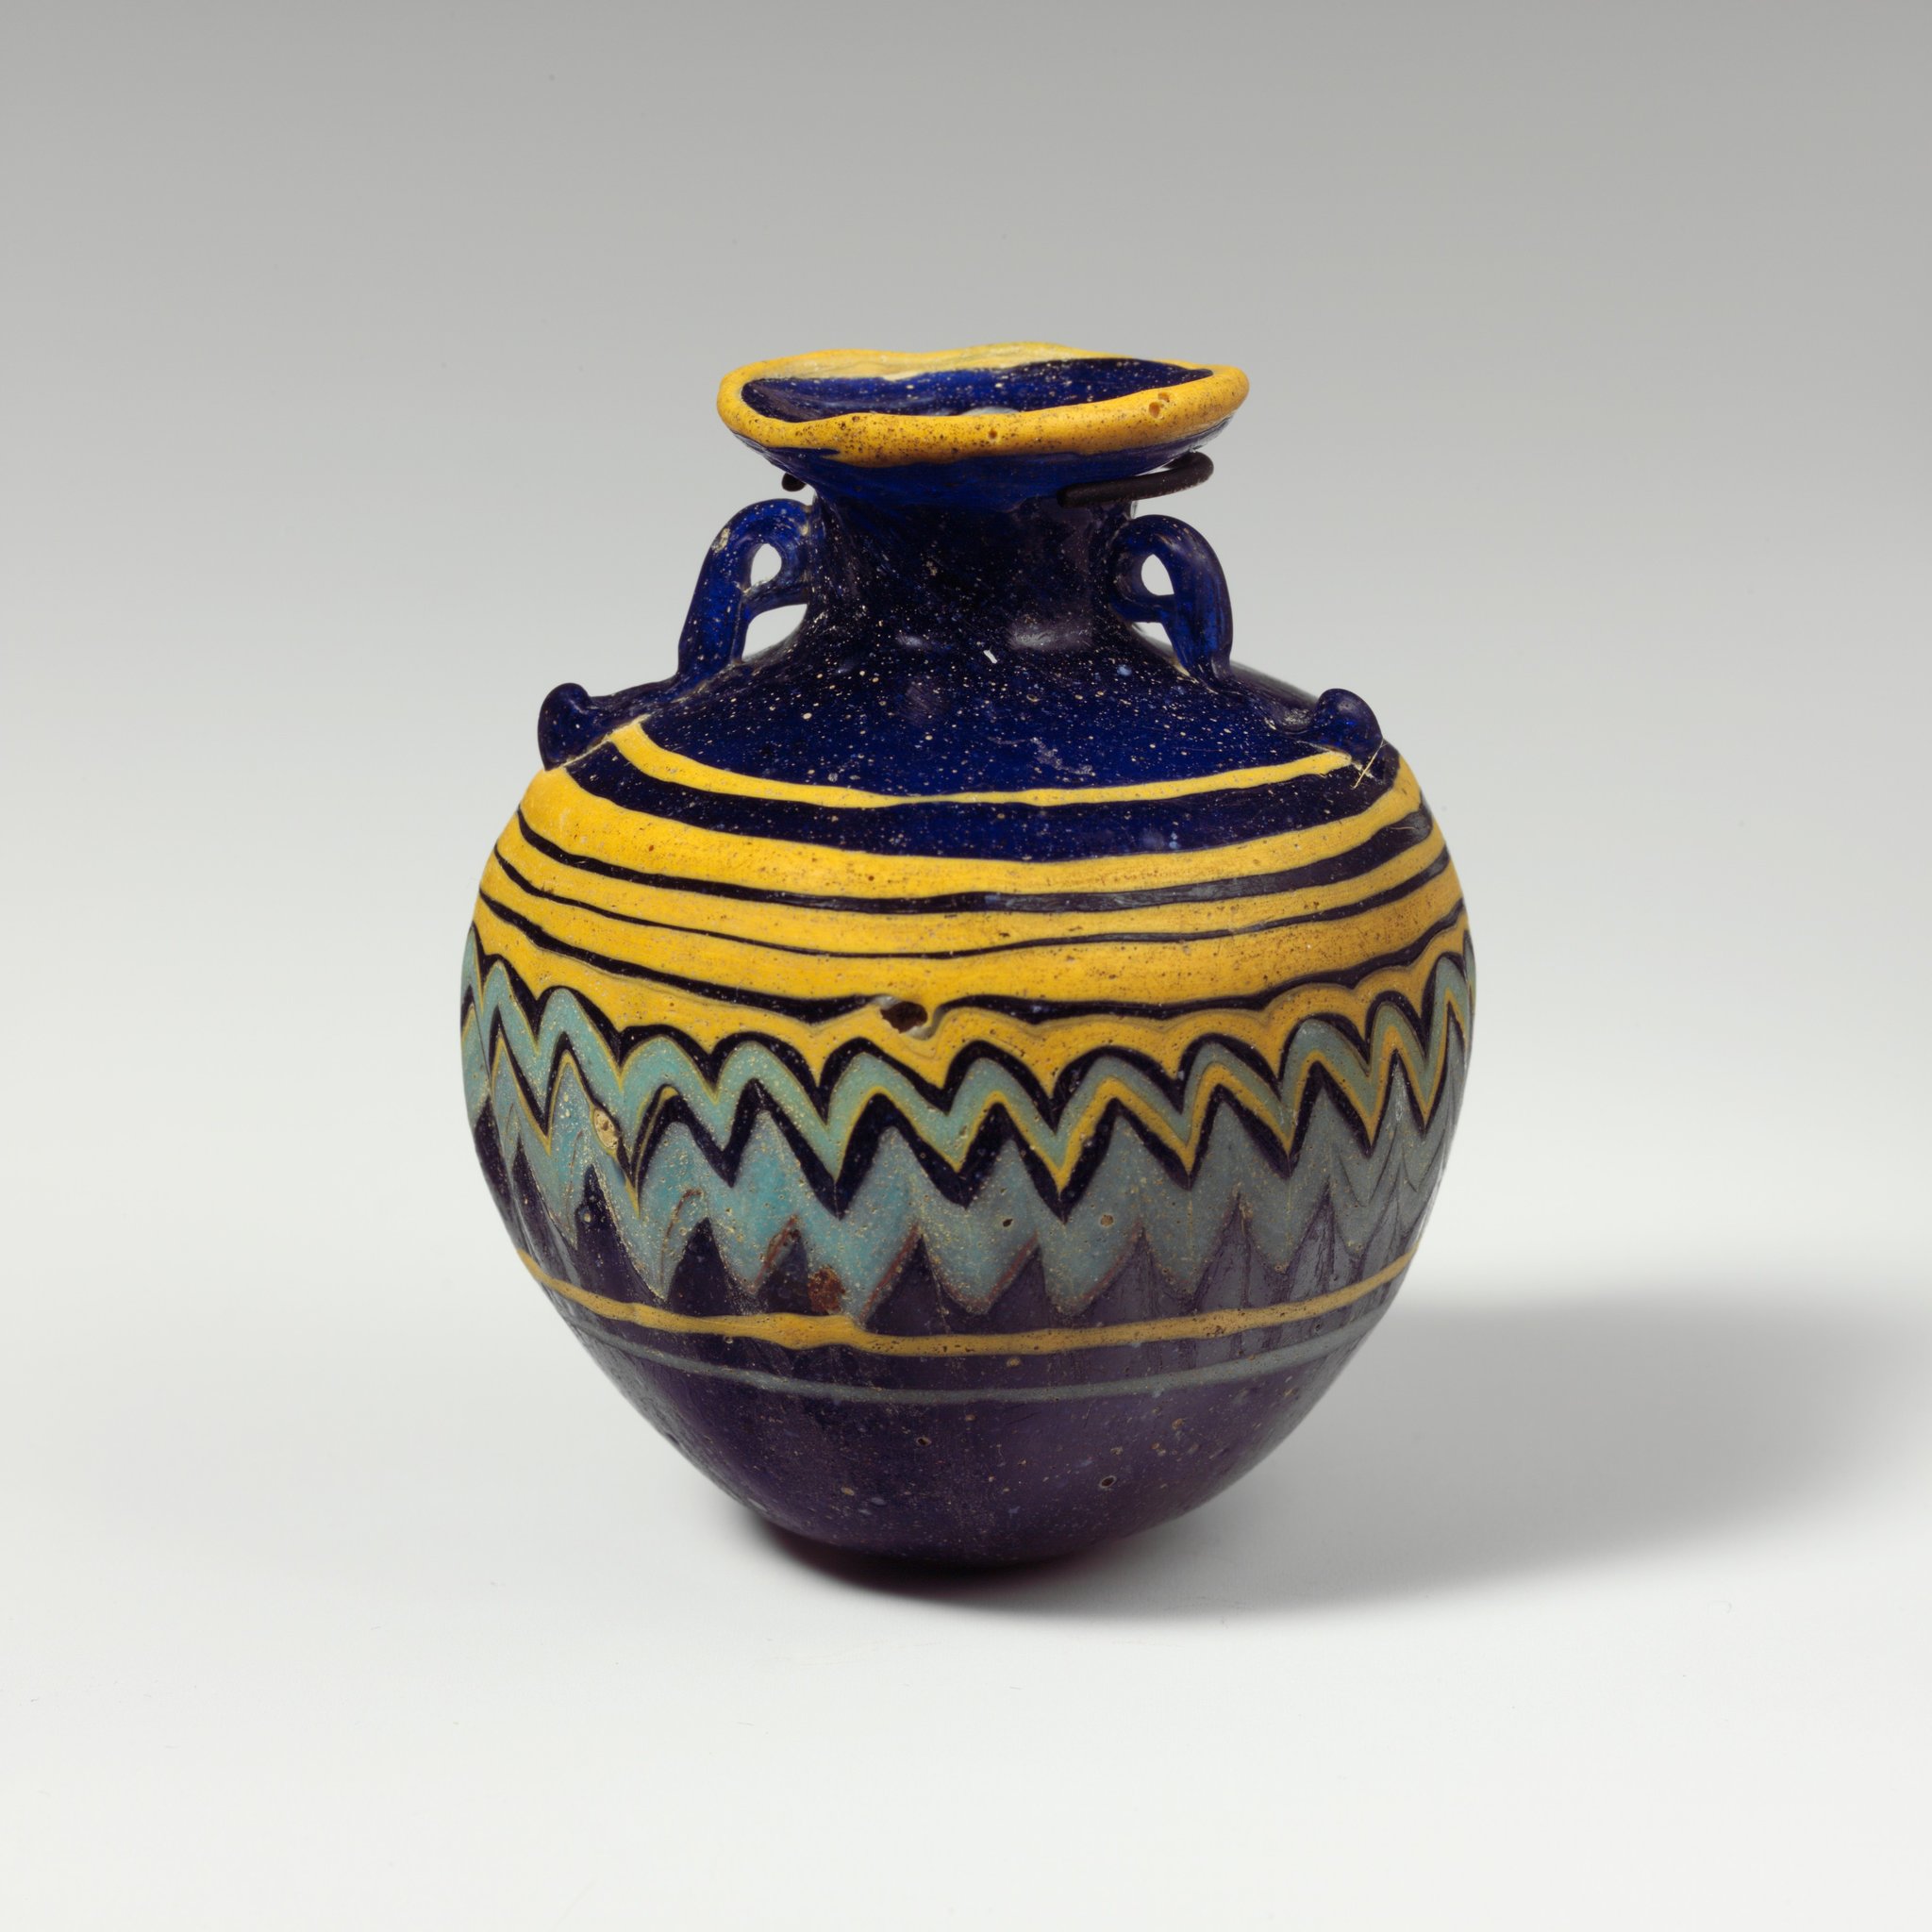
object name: aryballos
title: Glass aryballos (perfume bottle)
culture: greek, eastern mediterranean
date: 534-401 BCE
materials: glass